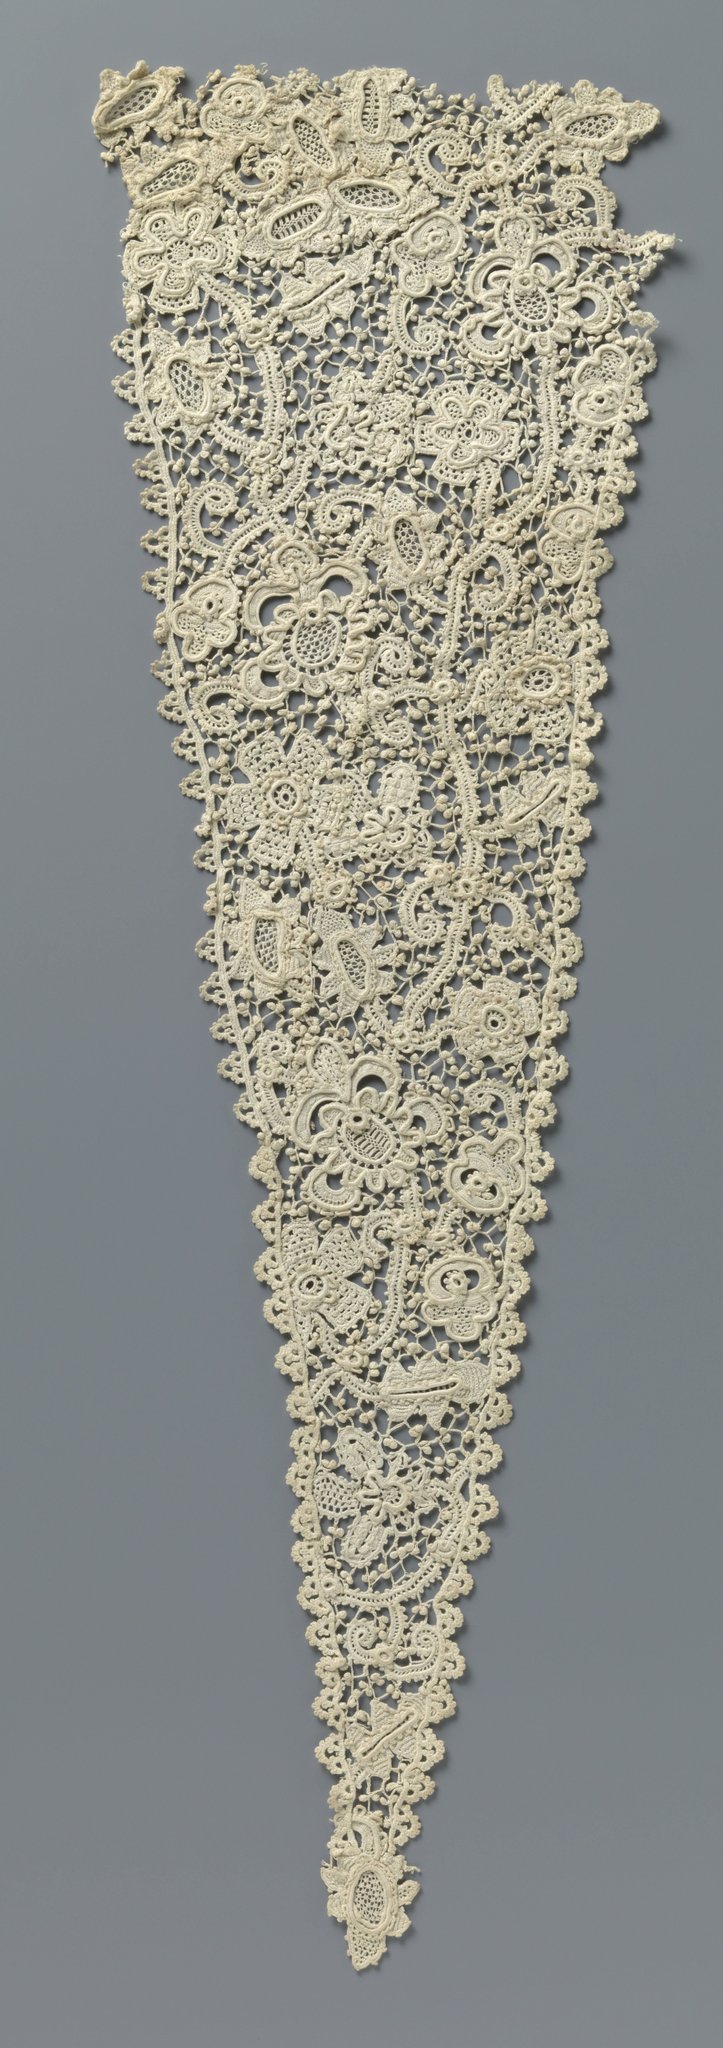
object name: oplegstuk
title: Oplegstuk van gehaakte kant imitatie grove Venetiaanse kant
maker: Anonymous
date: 1890-1909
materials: cotton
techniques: crocheted lace, irish crochet lace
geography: ireland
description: Het is een aanname dat deze Ierse gehaakte kant ook daadwerkelijk in Ierland is gemaakt. Ierse gehaakte kant kent zijn oorsprong rond 1760 en kwam vanaf 1840 in ontwikkeling. Aangezien volgens Martine Bruggeman (Kant in Europa) de Ierse haakindustrie aan het eind van de 19e eeuw gereorganiseerd werd en in populariteit groeide, is het hier beschreven stuk gedateerd rond 1890, tot 1909 vanwege de datering in het eerste decennium van populariteit van Ierse gehaakte kant volgens het Kantlexicon (Johan Coene).